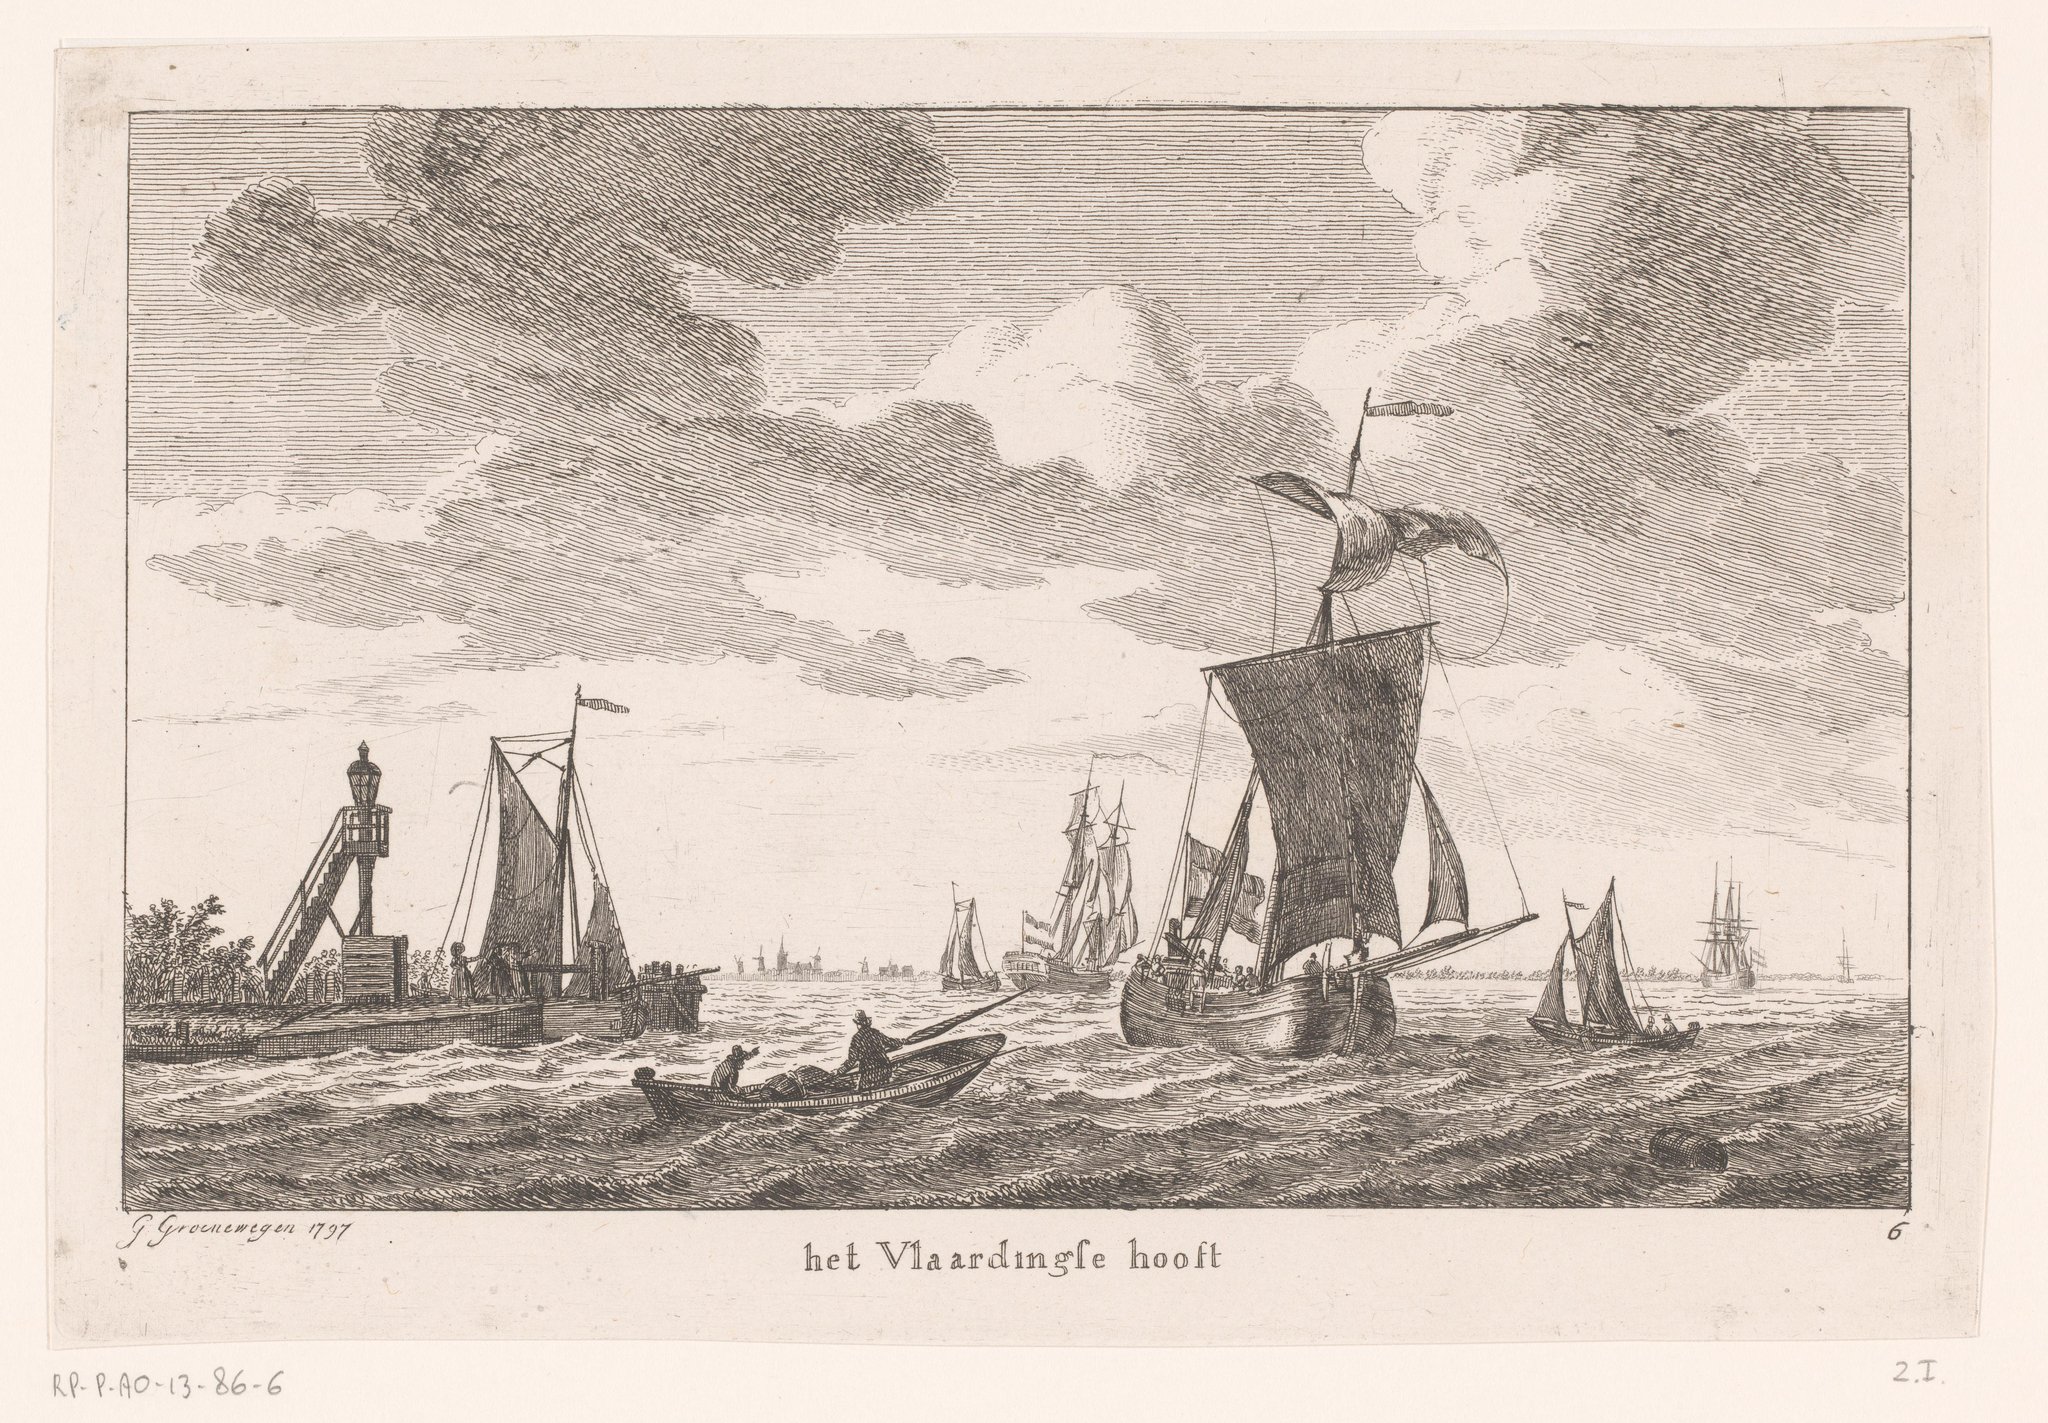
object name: print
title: Gezicht op het havenhoofd van Vlaardingen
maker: gerrit groenewegen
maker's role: draughtsman, print maker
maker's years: 1754-1826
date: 1797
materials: paper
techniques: etching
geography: rotterdam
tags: harbour, sailing-ship, sailing-boat, rowing-boat, canoe, etc.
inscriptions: date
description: Gezicht op de Maas en het havenhoofd van Vlaardingen (links). In het water een roeiboot en een aantal zeilschepen. Links op de achtergrond de contouren van Schiedam, rechts de zuidelijke Maasoever. Rechtsonder genummerd: 6. Deze prent maakt deel uit van een serie van zes prenten met Maasgezichten.